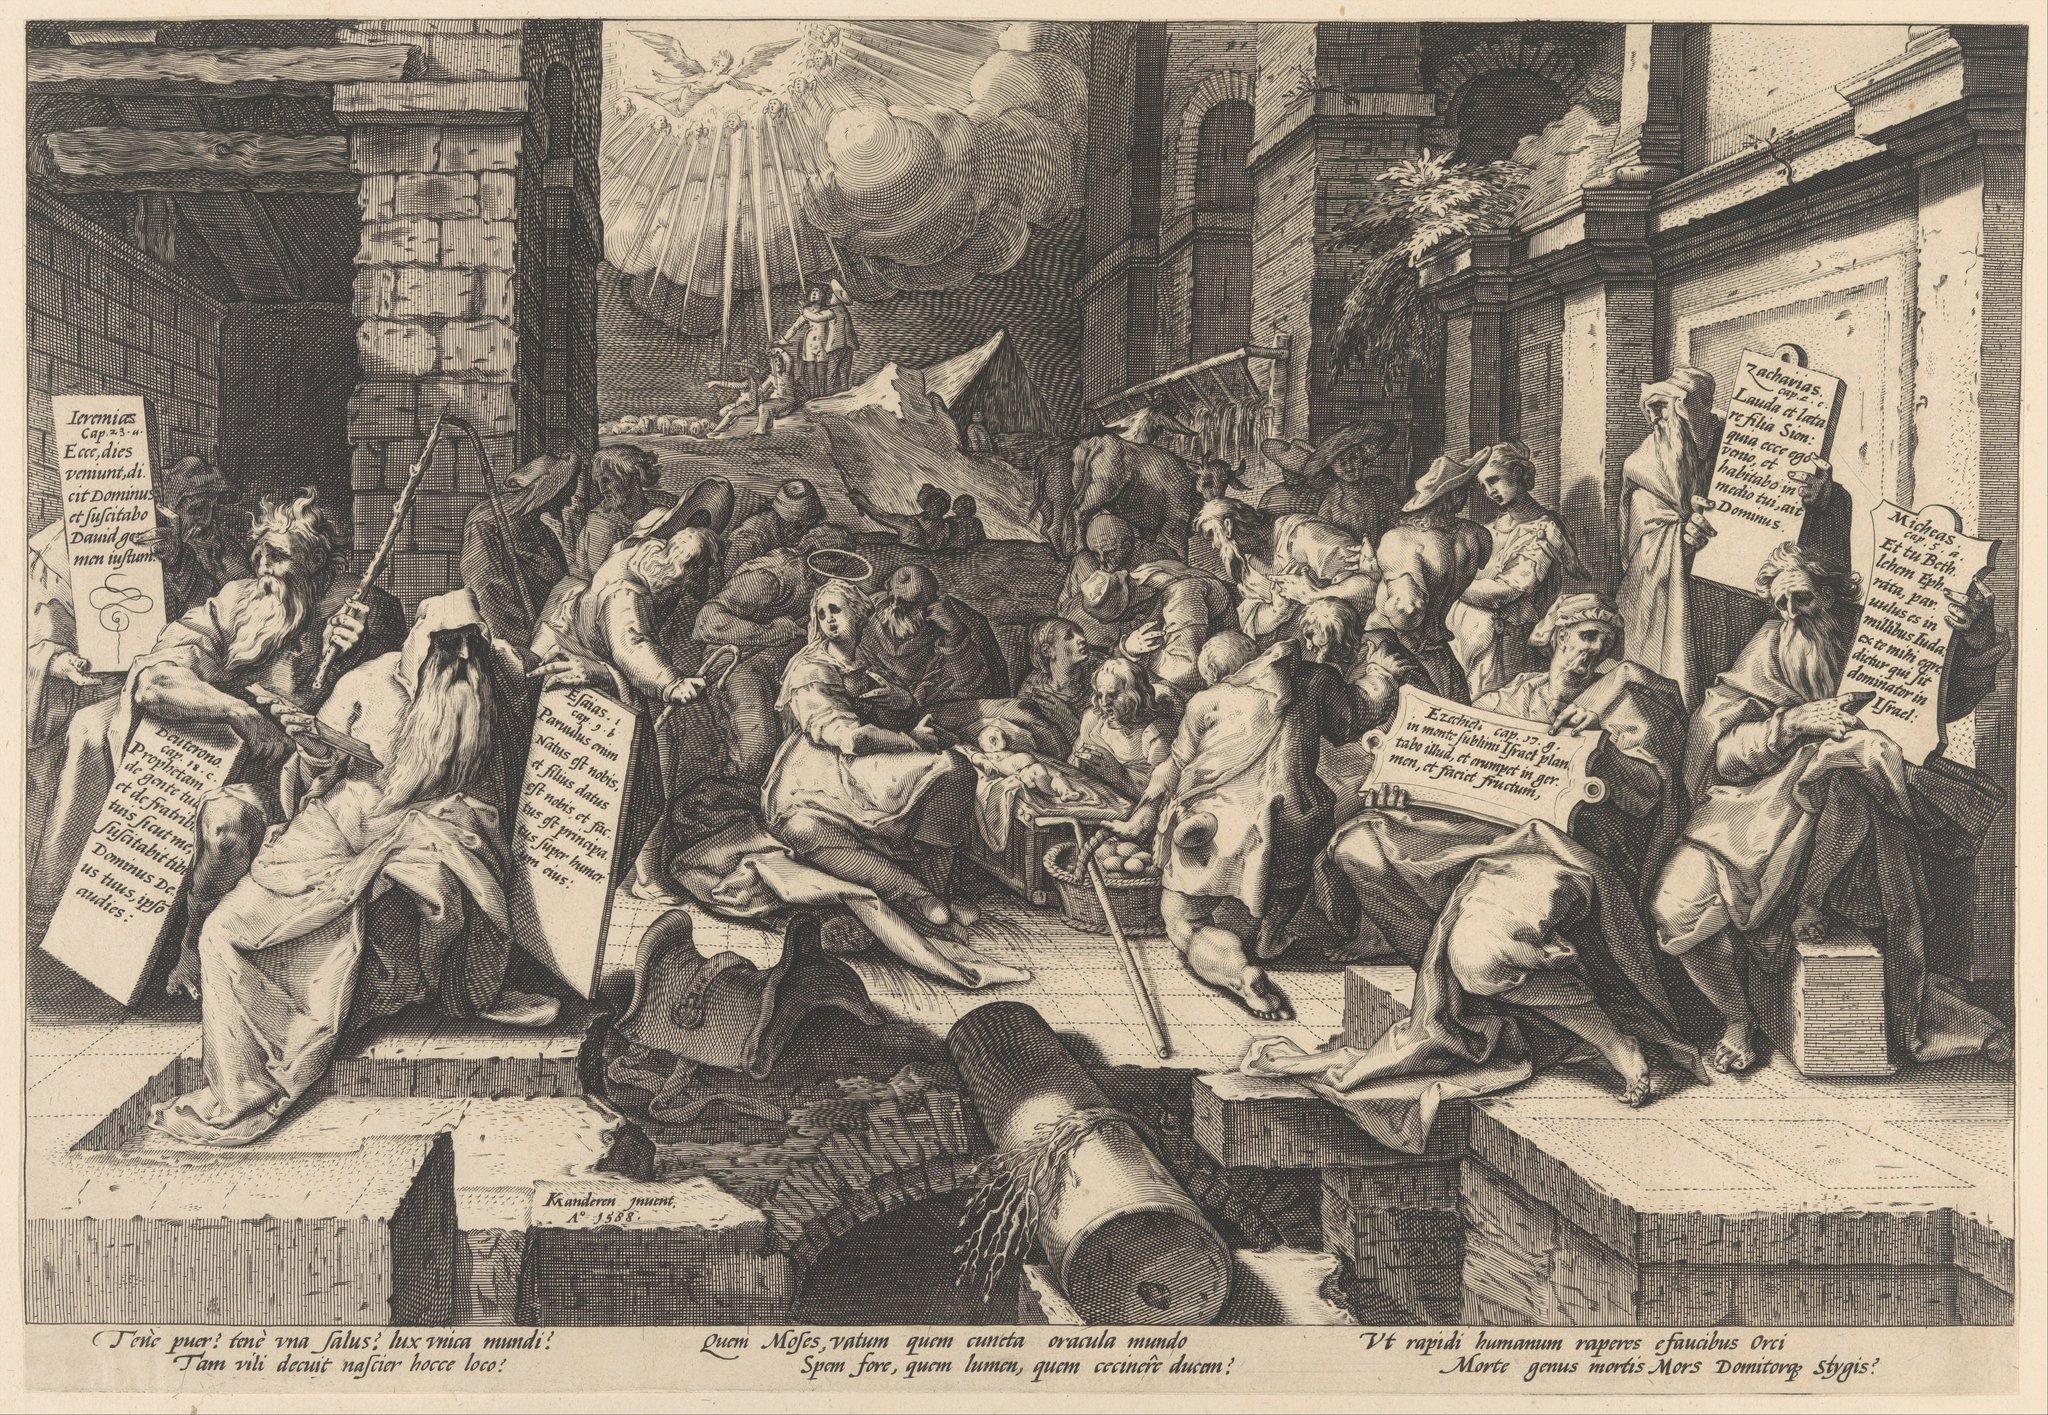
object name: print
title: The Adoration of the Shepherds, Surrounded by Moses and Five Prophets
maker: jacob matham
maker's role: artist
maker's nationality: netherlandish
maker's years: 1571-1631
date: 1588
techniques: engraving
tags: angels,moses,adoration of the shepherds